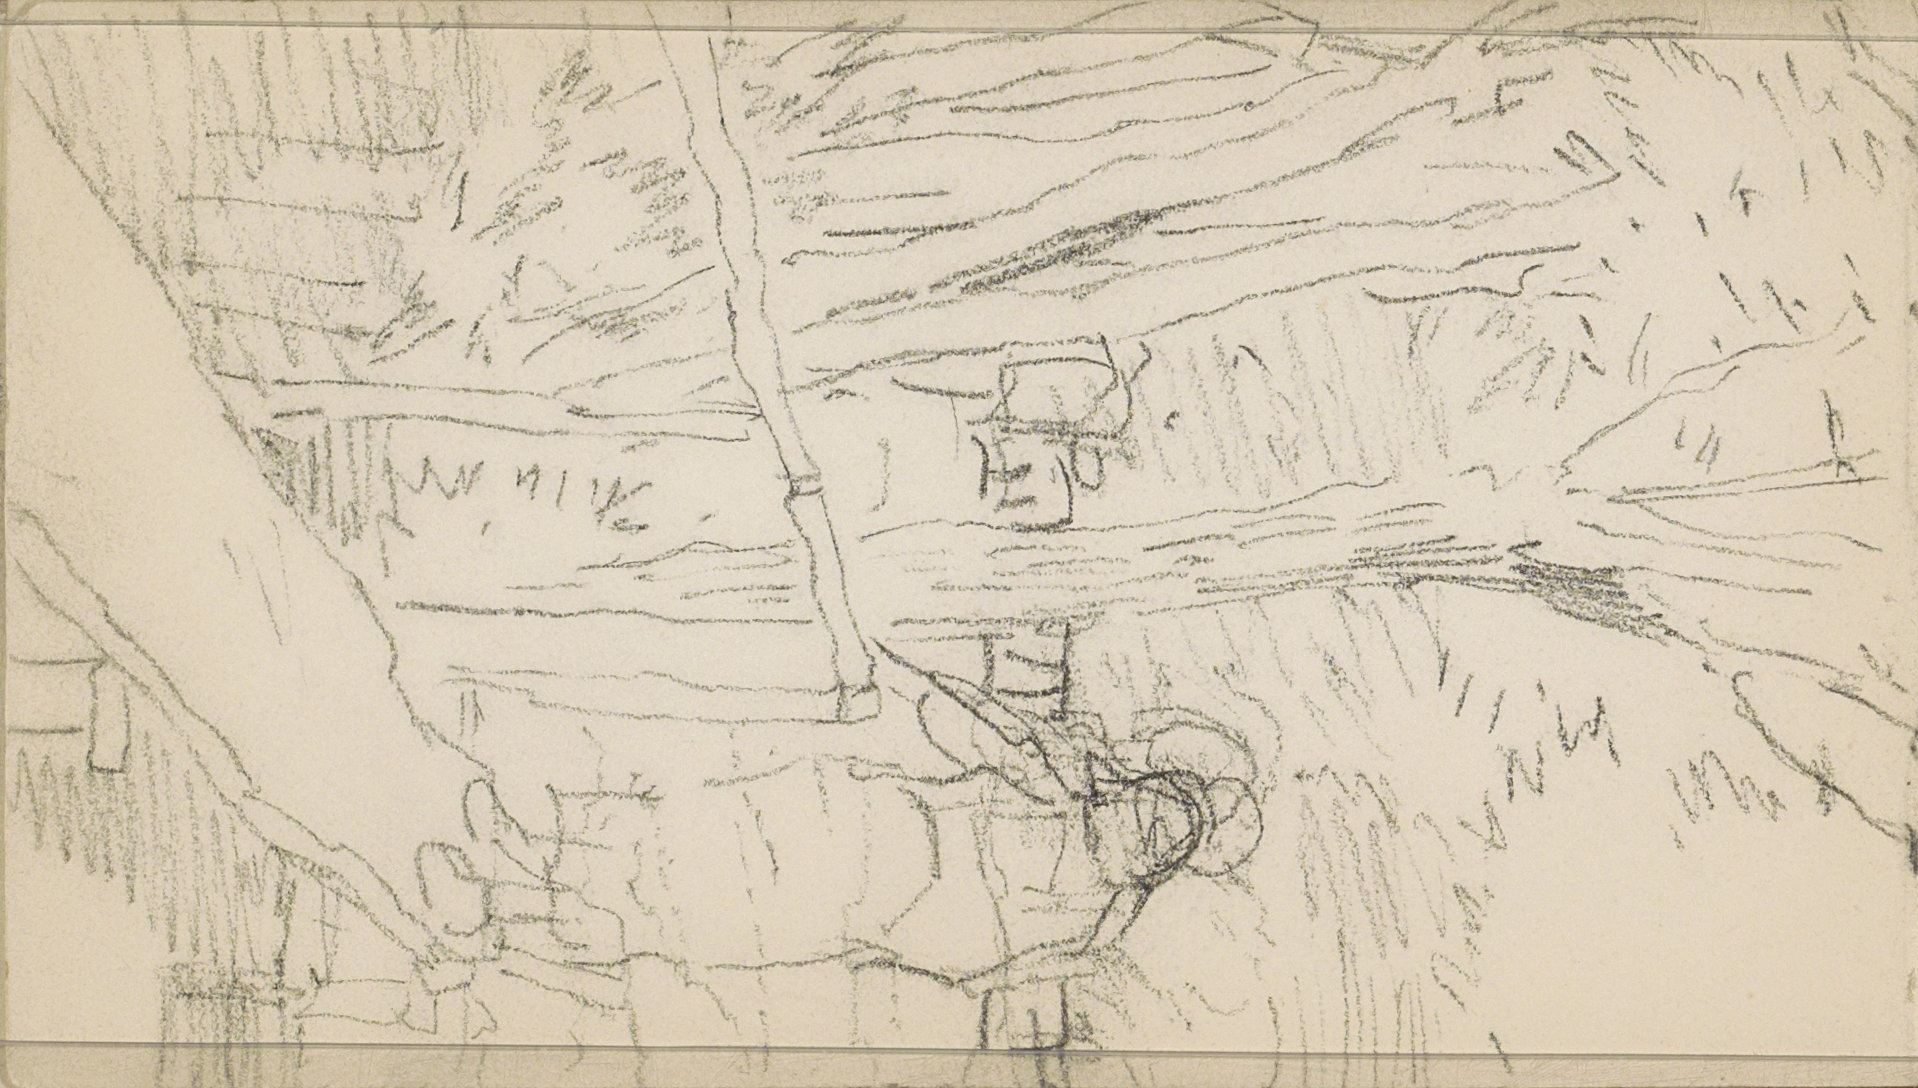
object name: sketchbook leaf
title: Figuur lopend op een houten loopplank over het water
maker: anton mauve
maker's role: draughtsman, painter, print maker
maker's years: 1838-1888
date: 1876-1879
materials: chalk, paper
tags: landscapes with waters, waterscapes, seascapes (in the temperate zone), bridge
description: Op de achtergrond de waterkant en enkele boerenwoningen. Blad 27 verso uit een schetsboek met 33 bladen.